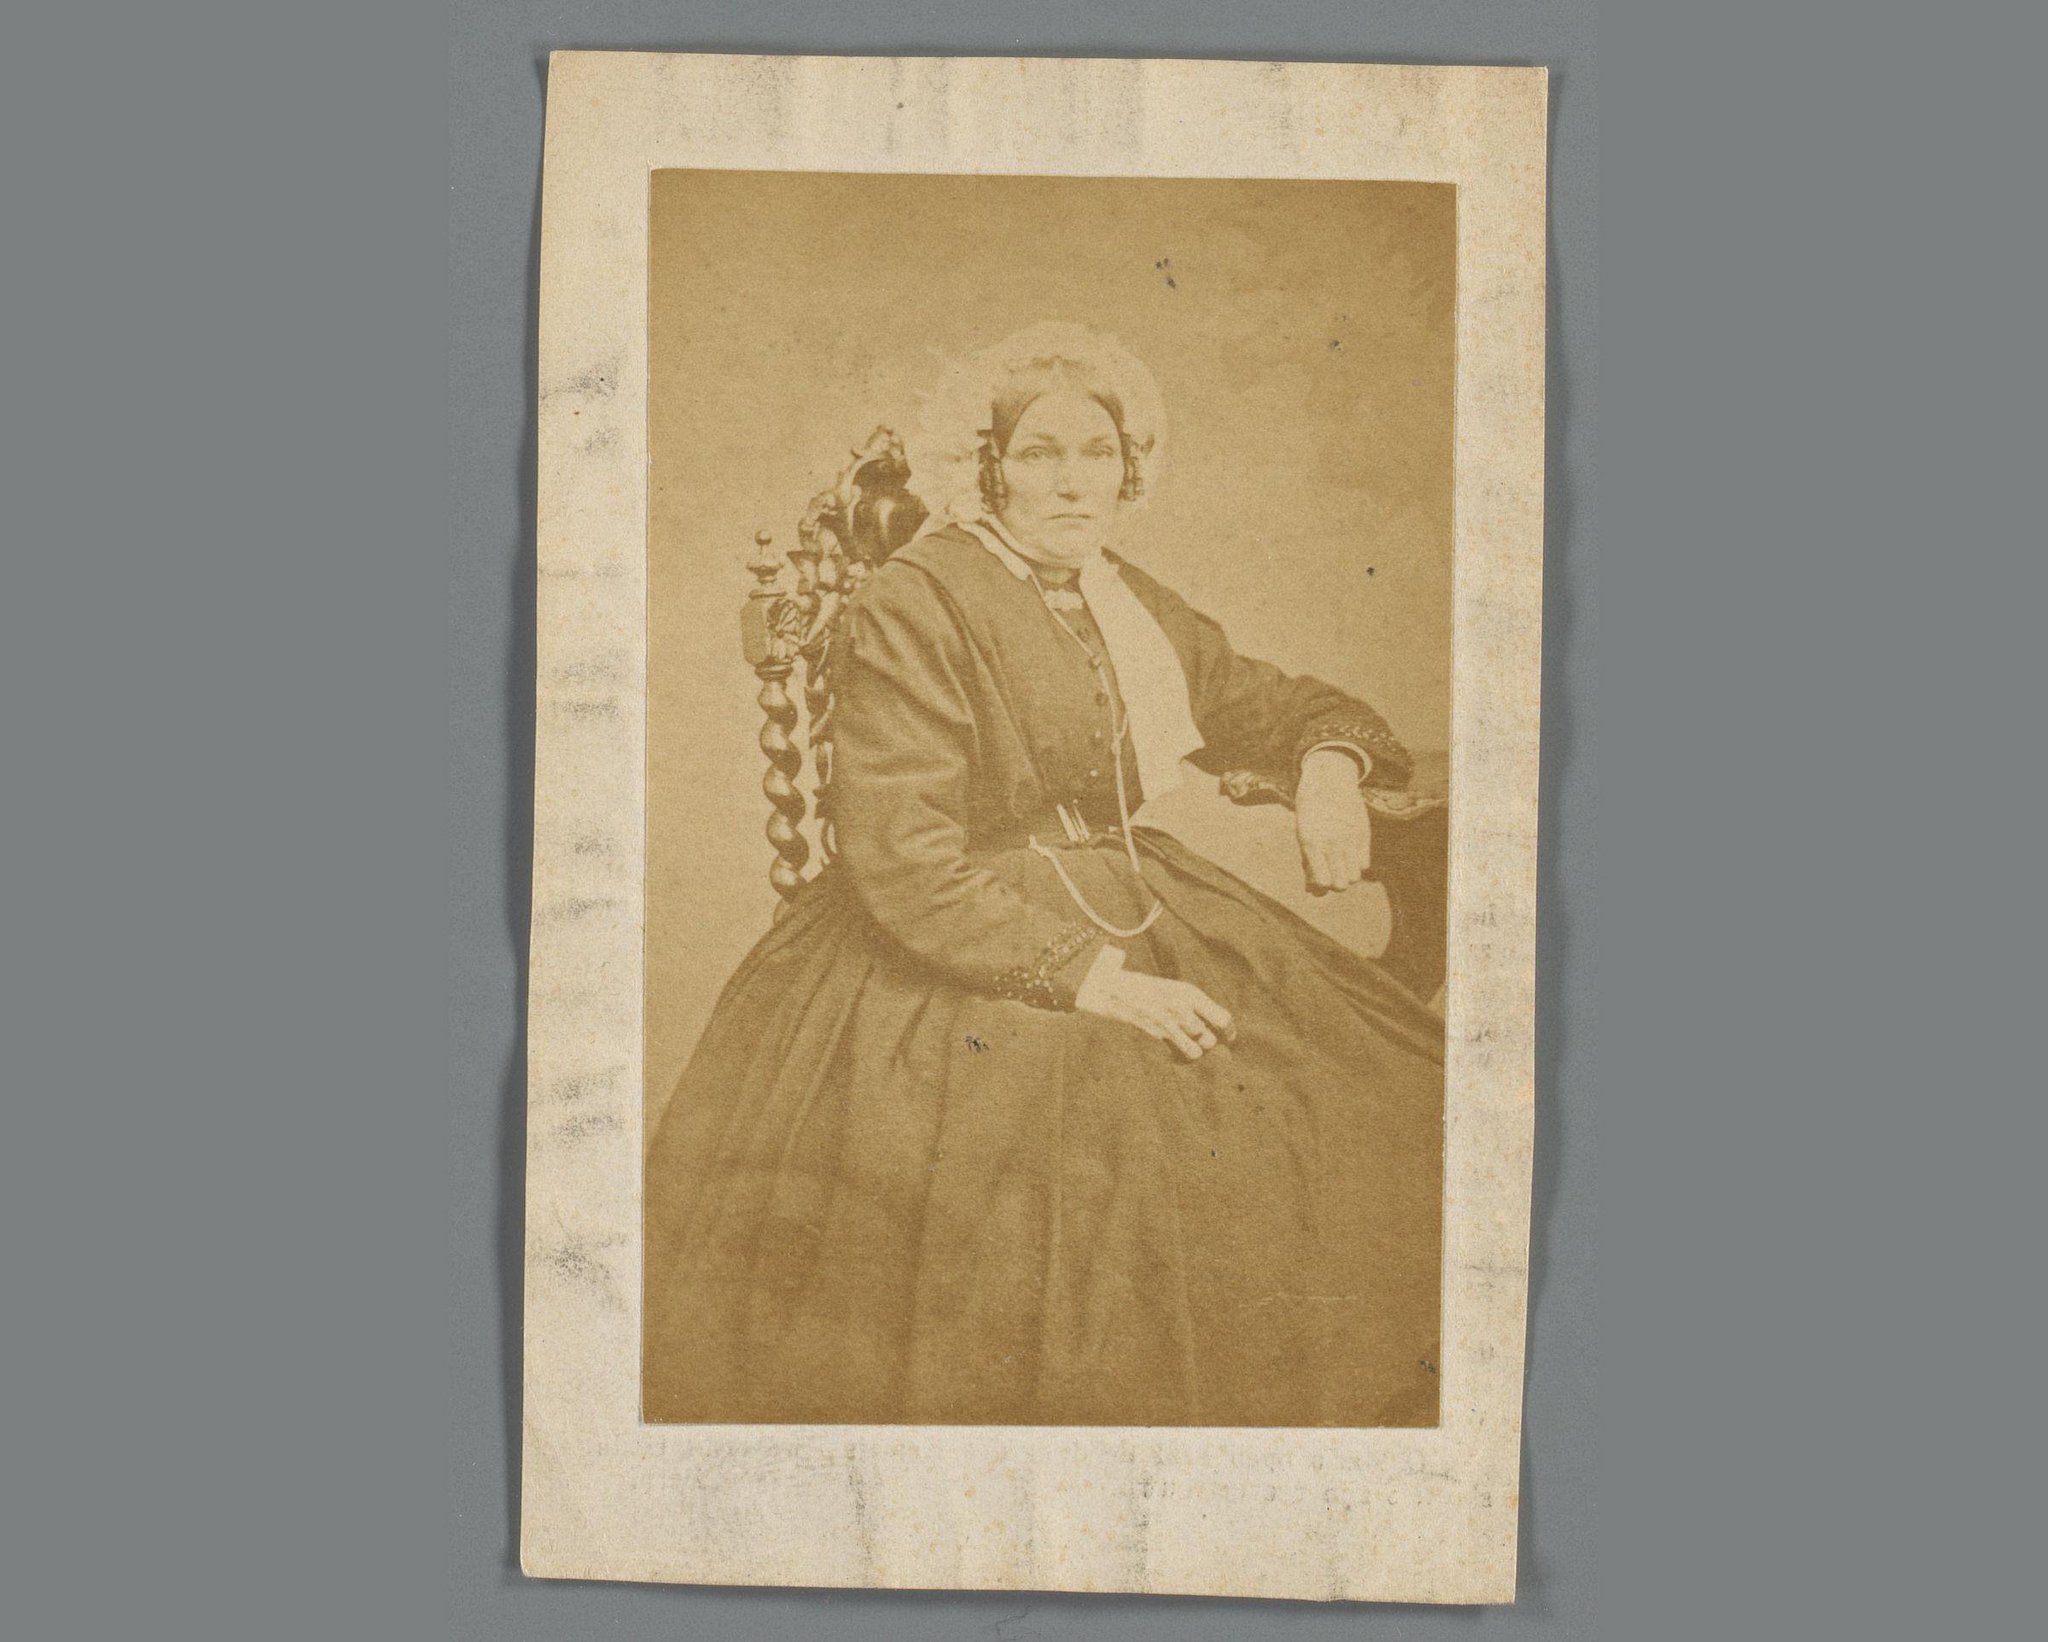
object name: prayer card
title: Portret van Joanna de Bruijn op bidprent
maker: Anonymous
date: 1870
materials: paper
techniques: albumen print, letterpress printing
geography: ravenstein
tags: historical persons, old woman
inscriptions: inscription: ‘Zoet Hart van Maria wees mijne toevlucht en mijn heil./ (300 dagen aflaat) (...) R.I.P.’